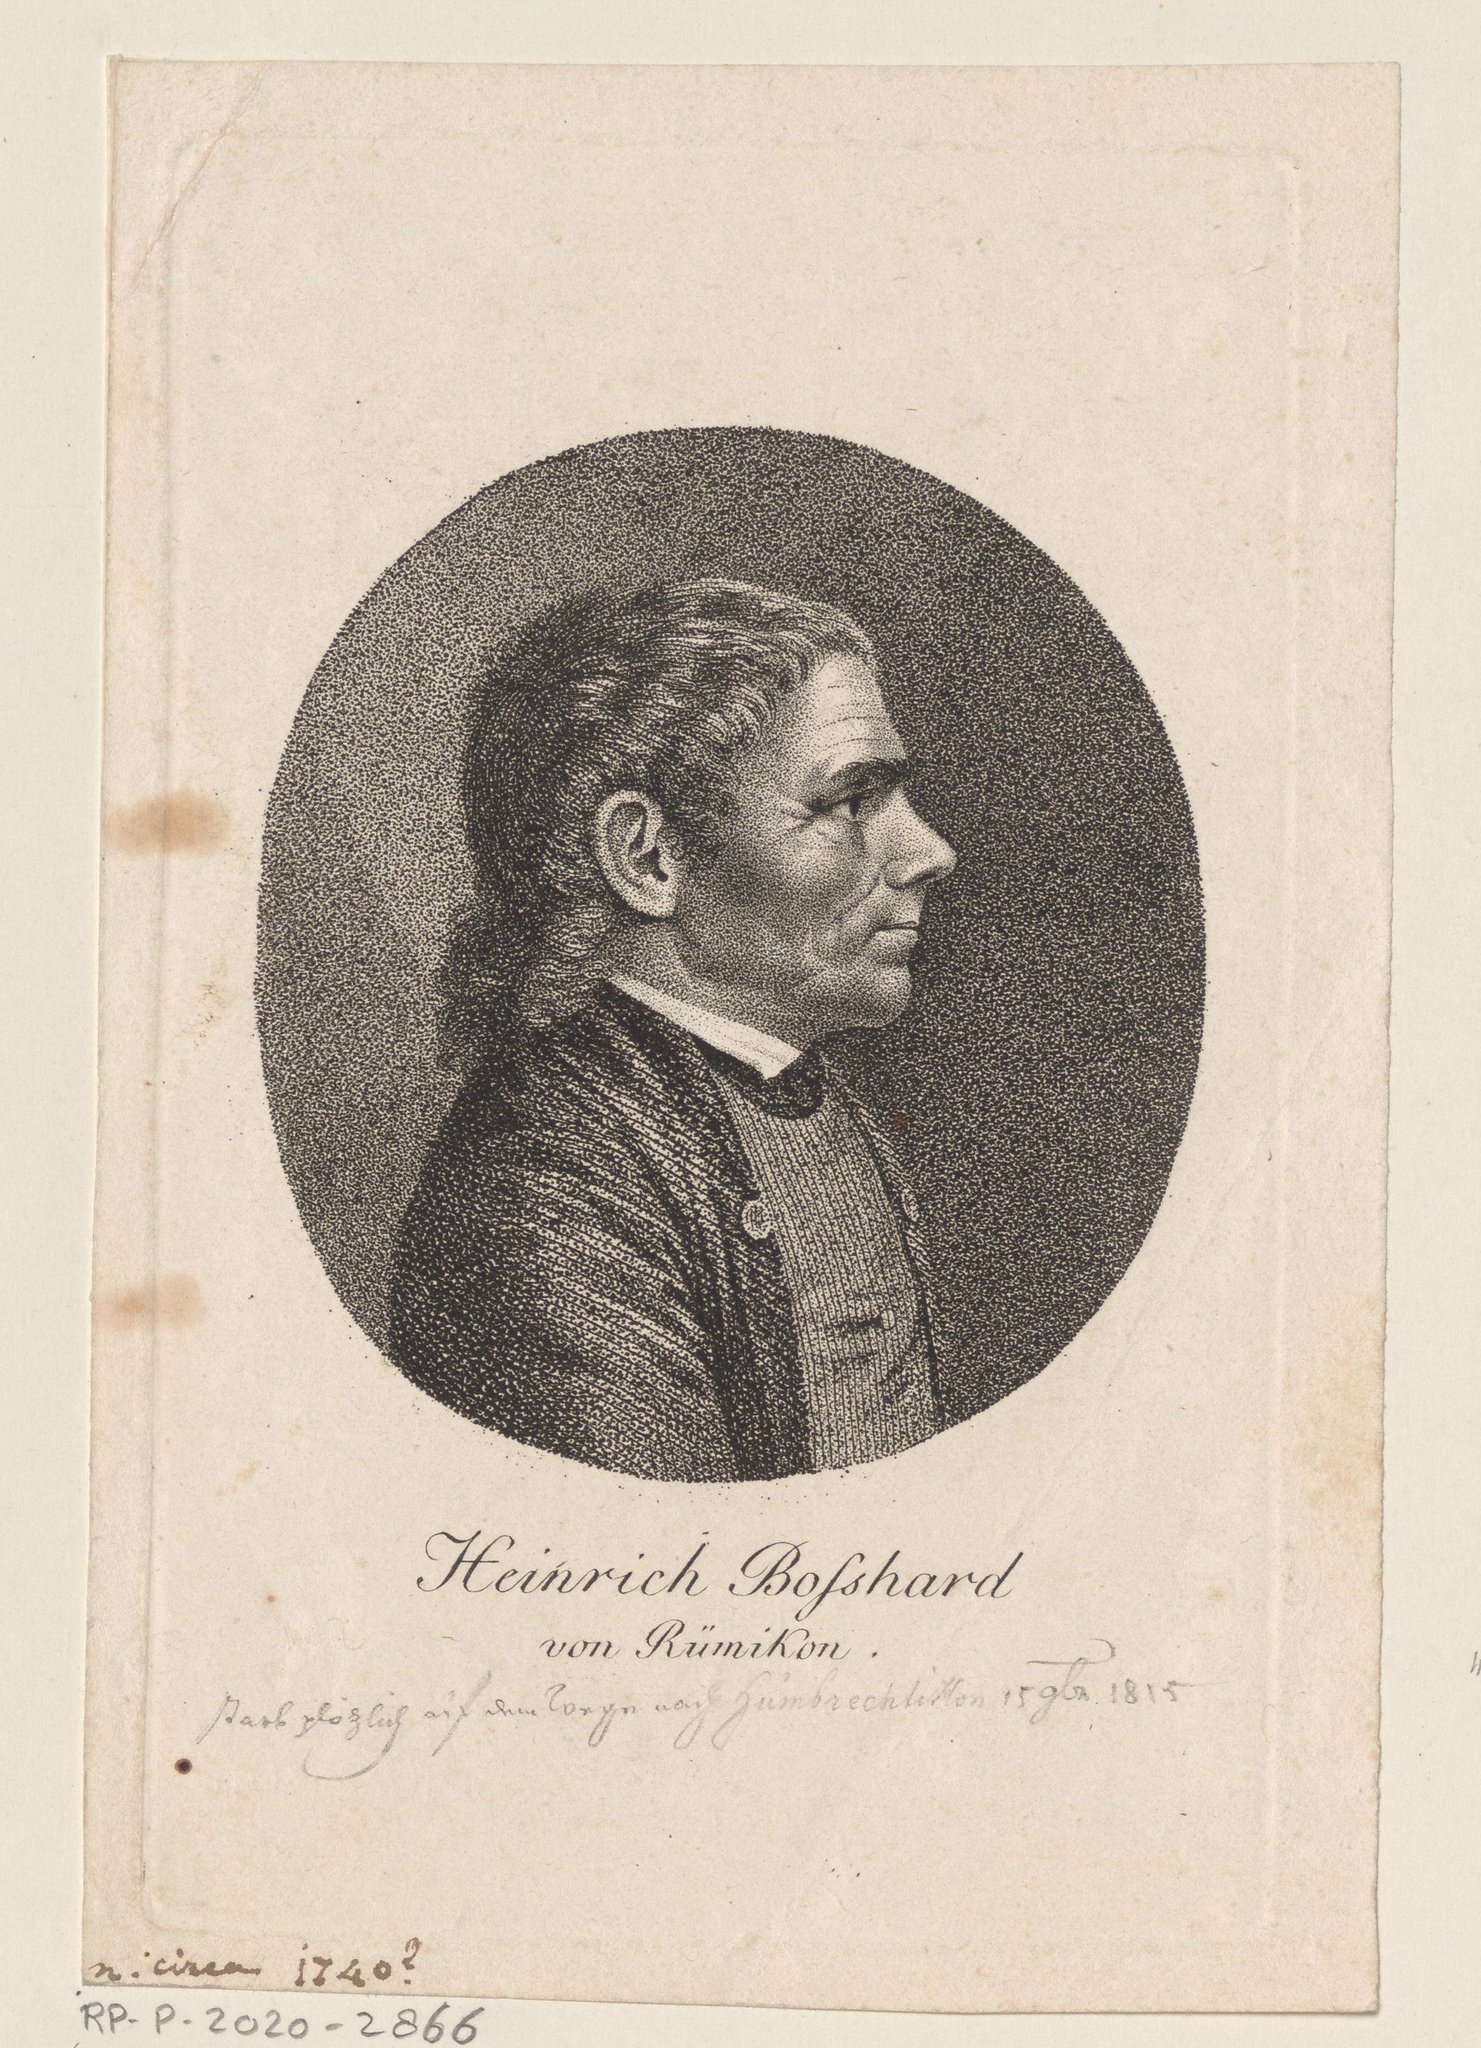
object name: print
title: Portret van Heinrich Bosshard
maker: Anonymous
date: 1800-1820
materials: paper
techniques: engraving, etching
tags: historical persons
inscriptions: inscription: ‘n. circa 1740?’